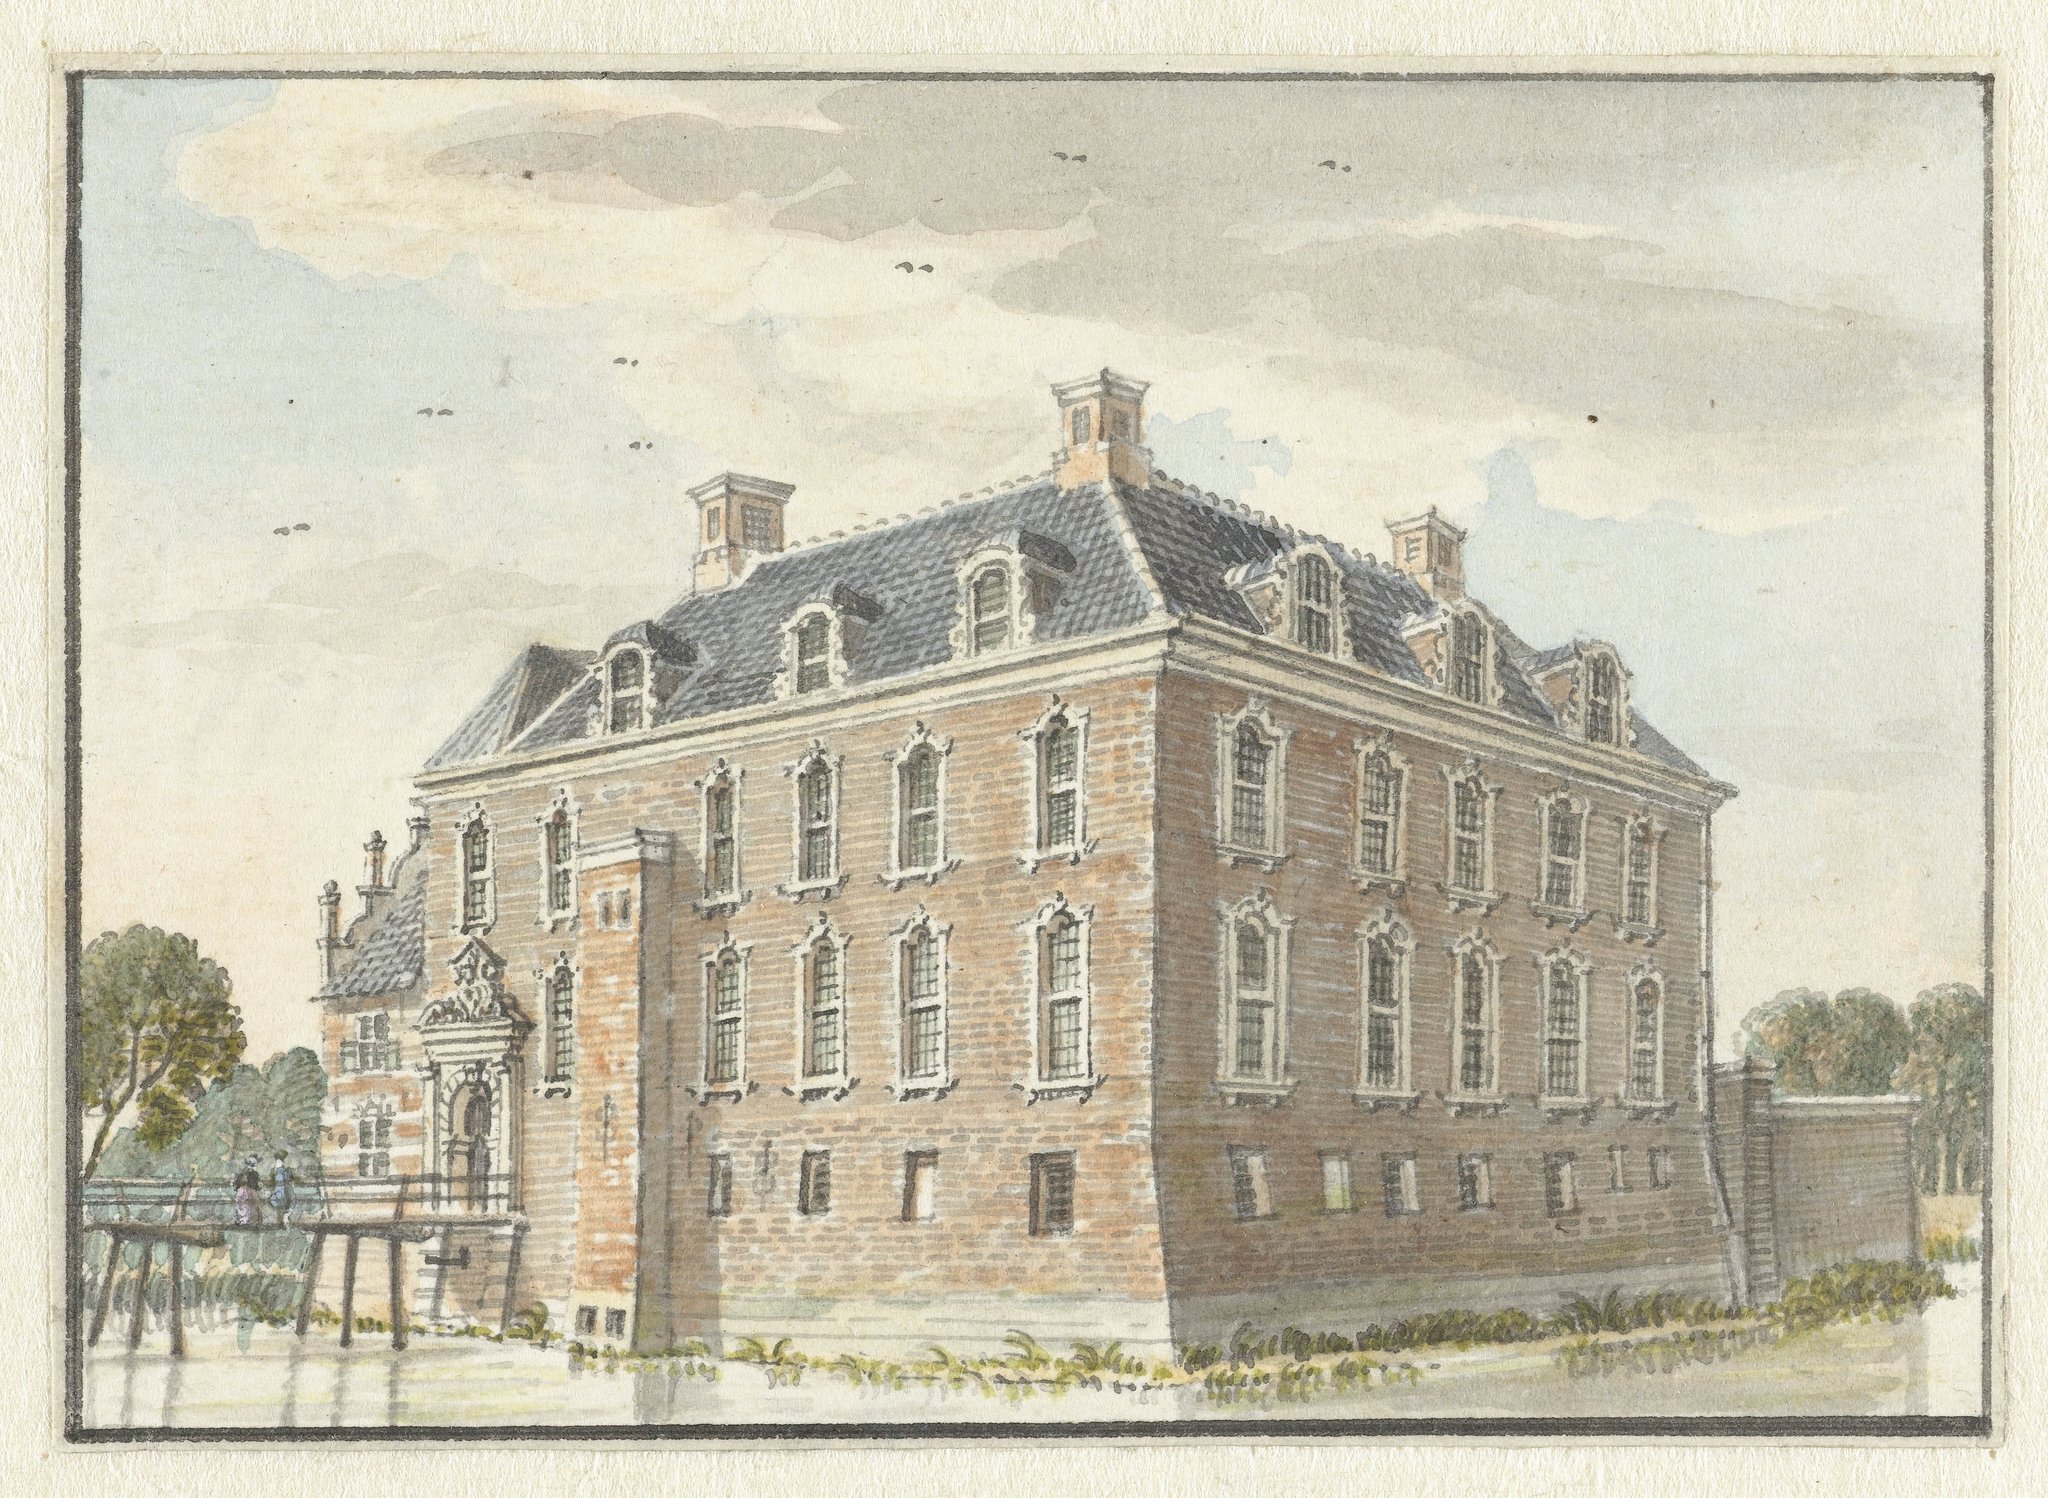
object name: watercolor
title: Het Huis te Baek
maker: jan de beijer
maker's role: draughtsman, print maker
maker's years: 1703-1780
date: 1743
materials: ink, paper, watercolor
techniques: brush, pen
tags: castle